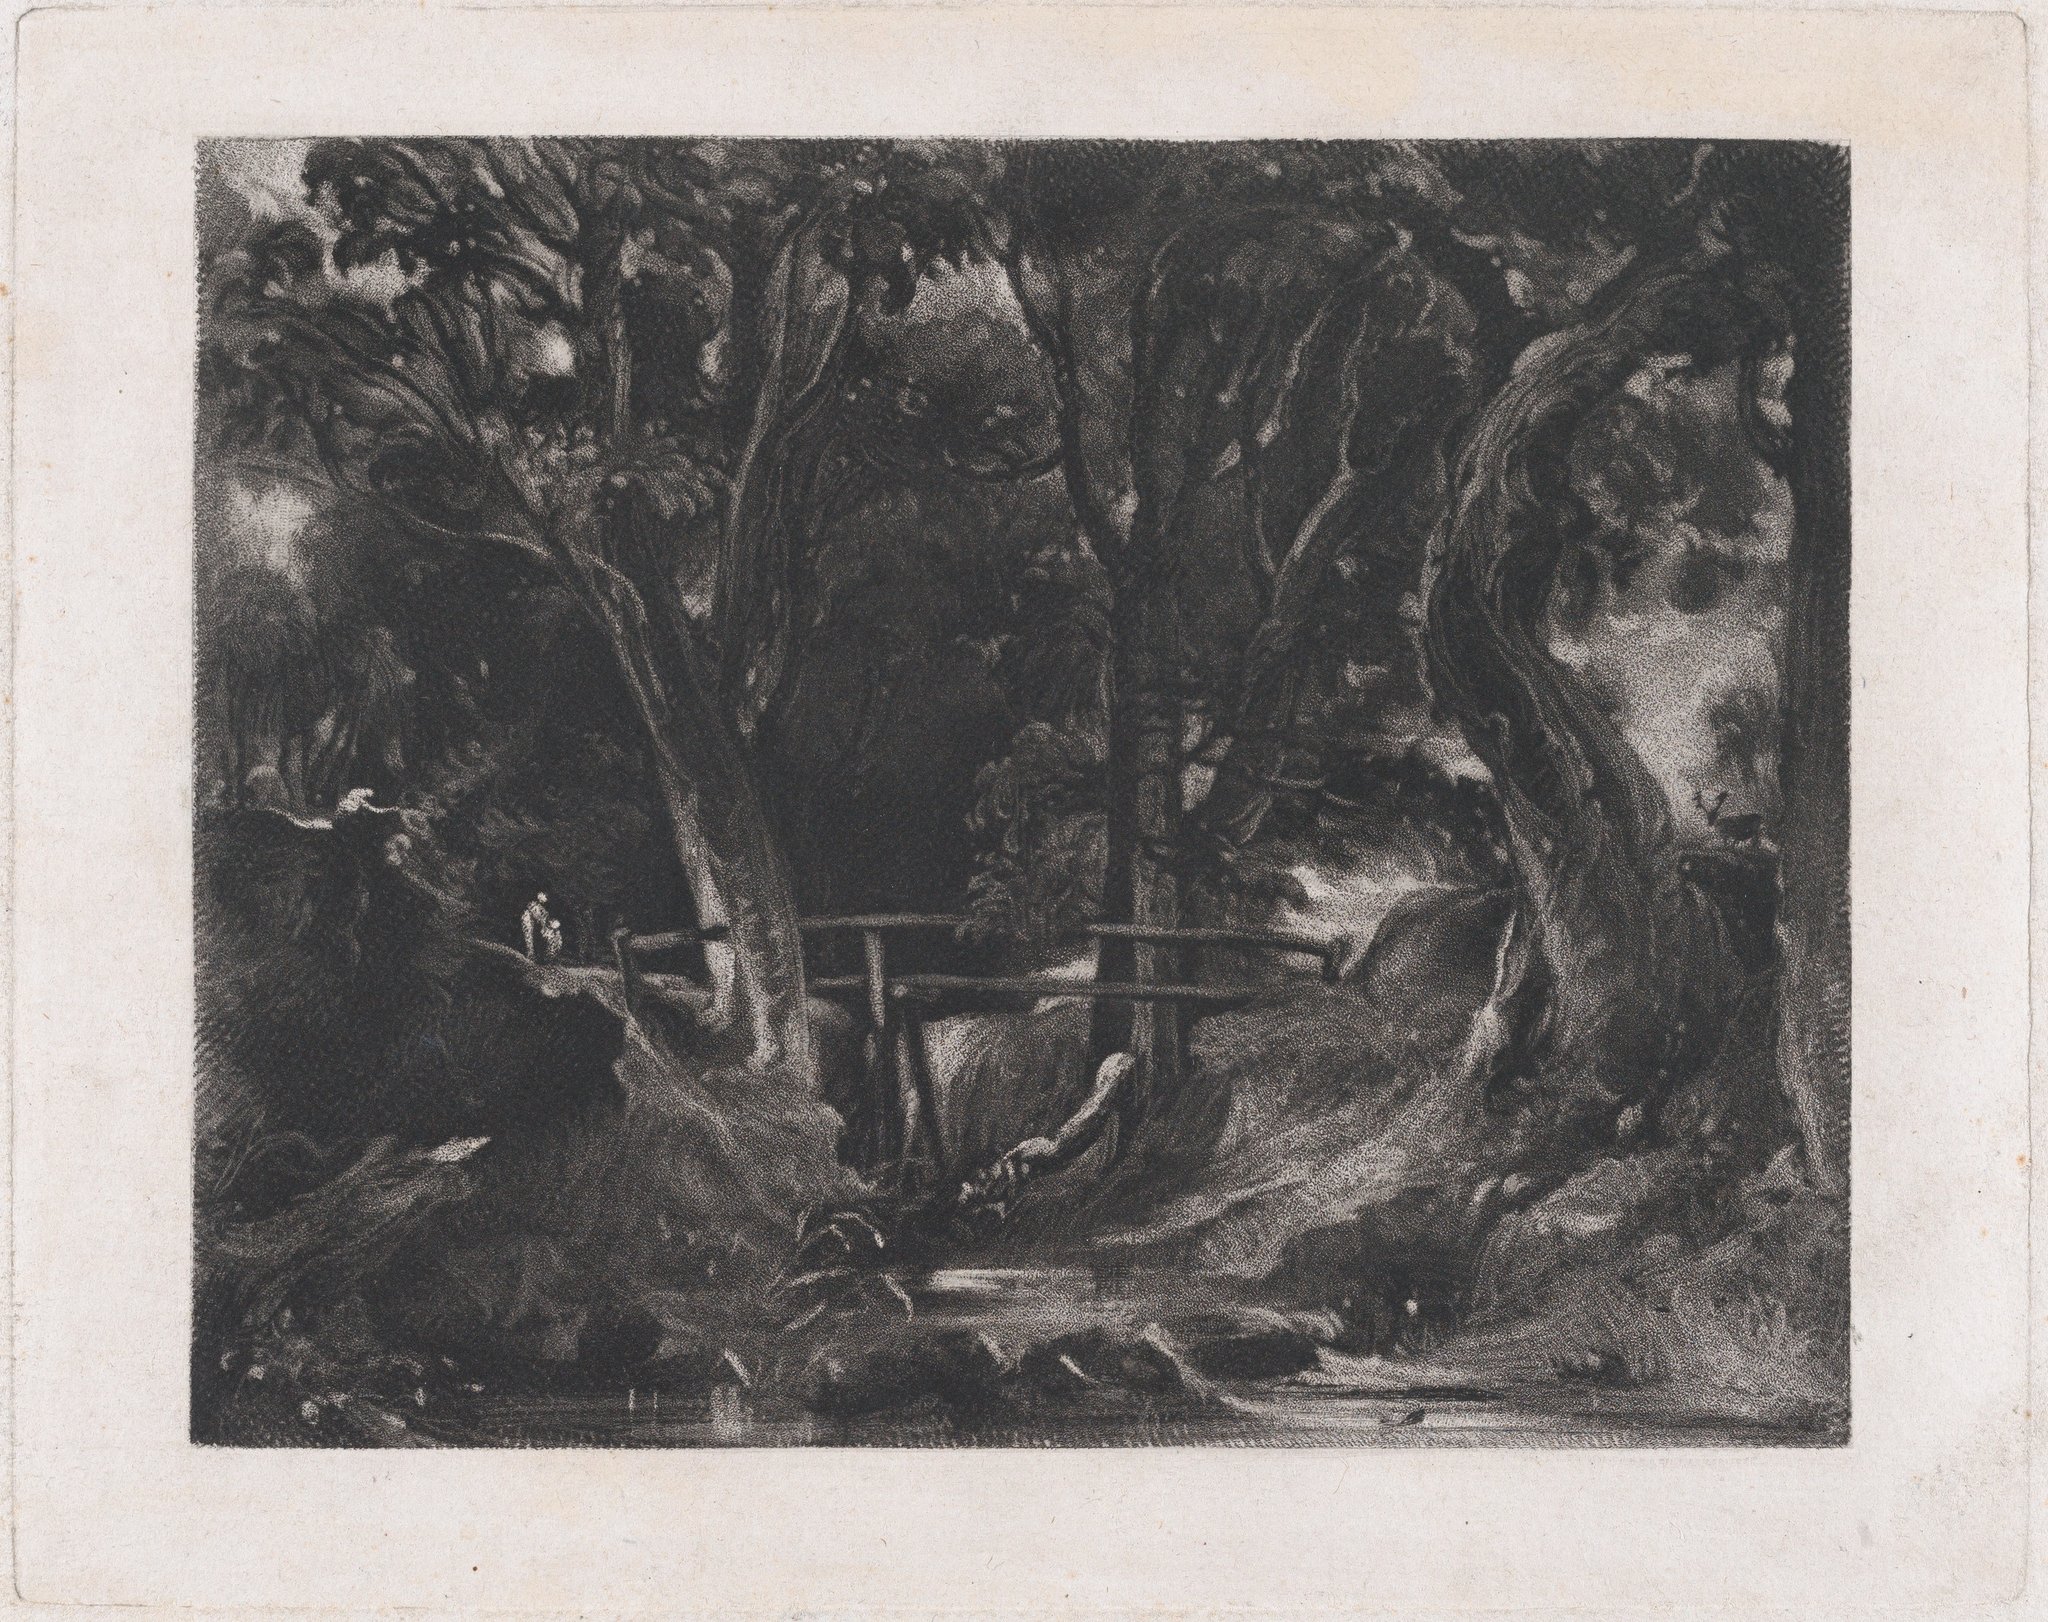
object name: print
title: A Dell, Helmingham Park, Suffolk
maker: david lucas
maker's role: artist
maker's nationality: british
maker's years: 1802-1881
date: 1830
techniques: mezzotint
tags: parks,trees